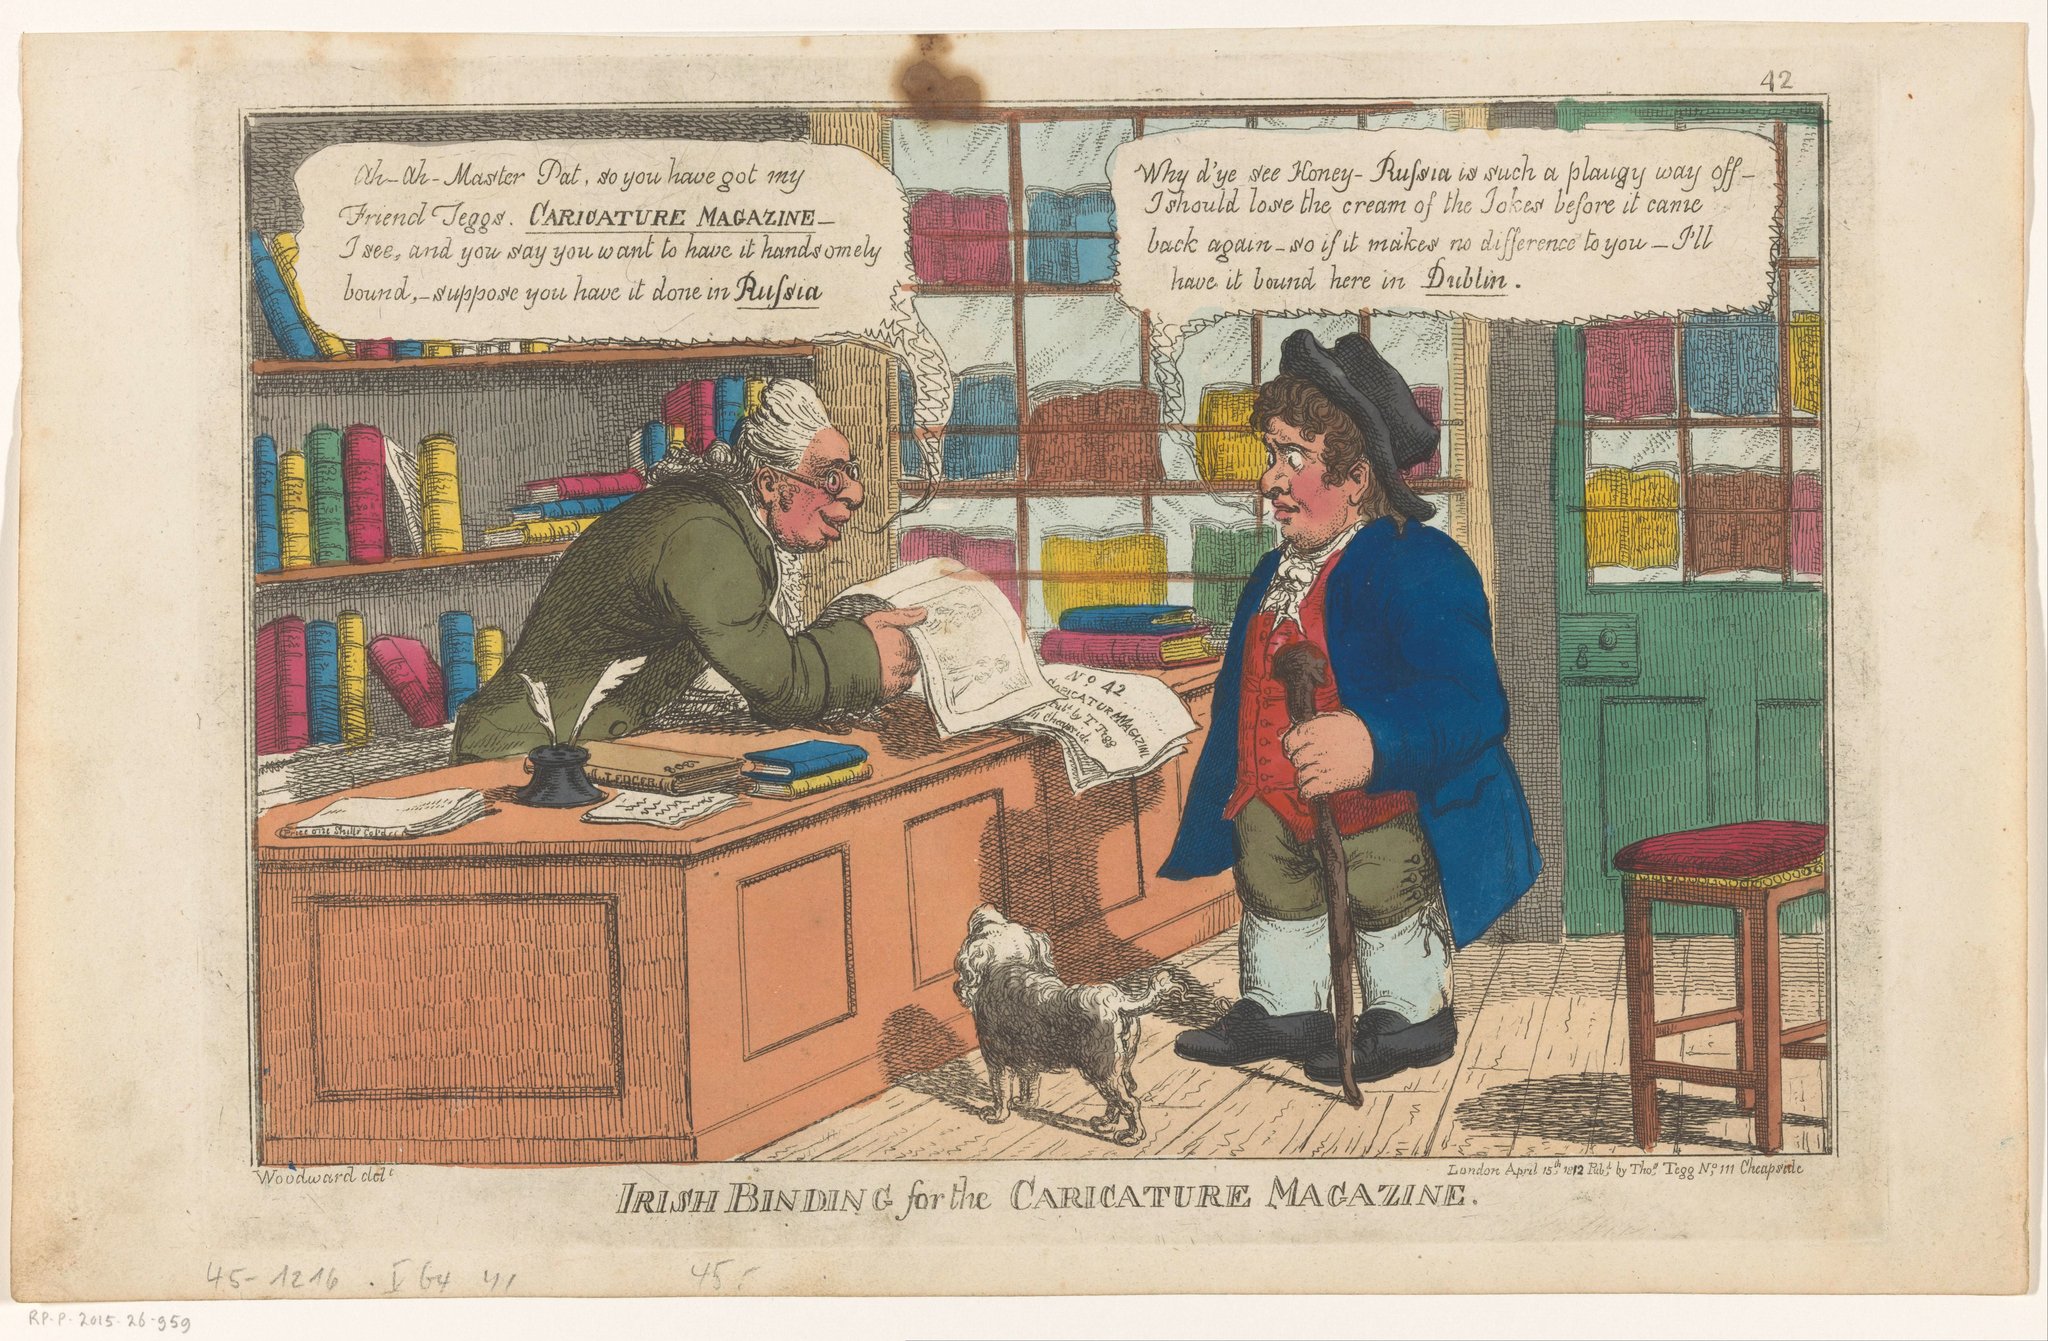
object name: print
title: Boekhandelaar in gesprek met een klant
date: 1805-1812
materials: paper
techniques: etching, hand coloring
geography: london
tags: bookbinding, counter ~ shop, political caricatures and satires, book-shop, bookseller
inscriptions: collector's mark: Lugt 2228, collector's mark: Lugt 4779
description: Op de toonbank van een boekhandel liggen platen uit 'The Caricature Magazine'. De boekhandelaar is in gesprek met een klant die deze wil laten inbinden. Rechtsboven genummerd: 42.